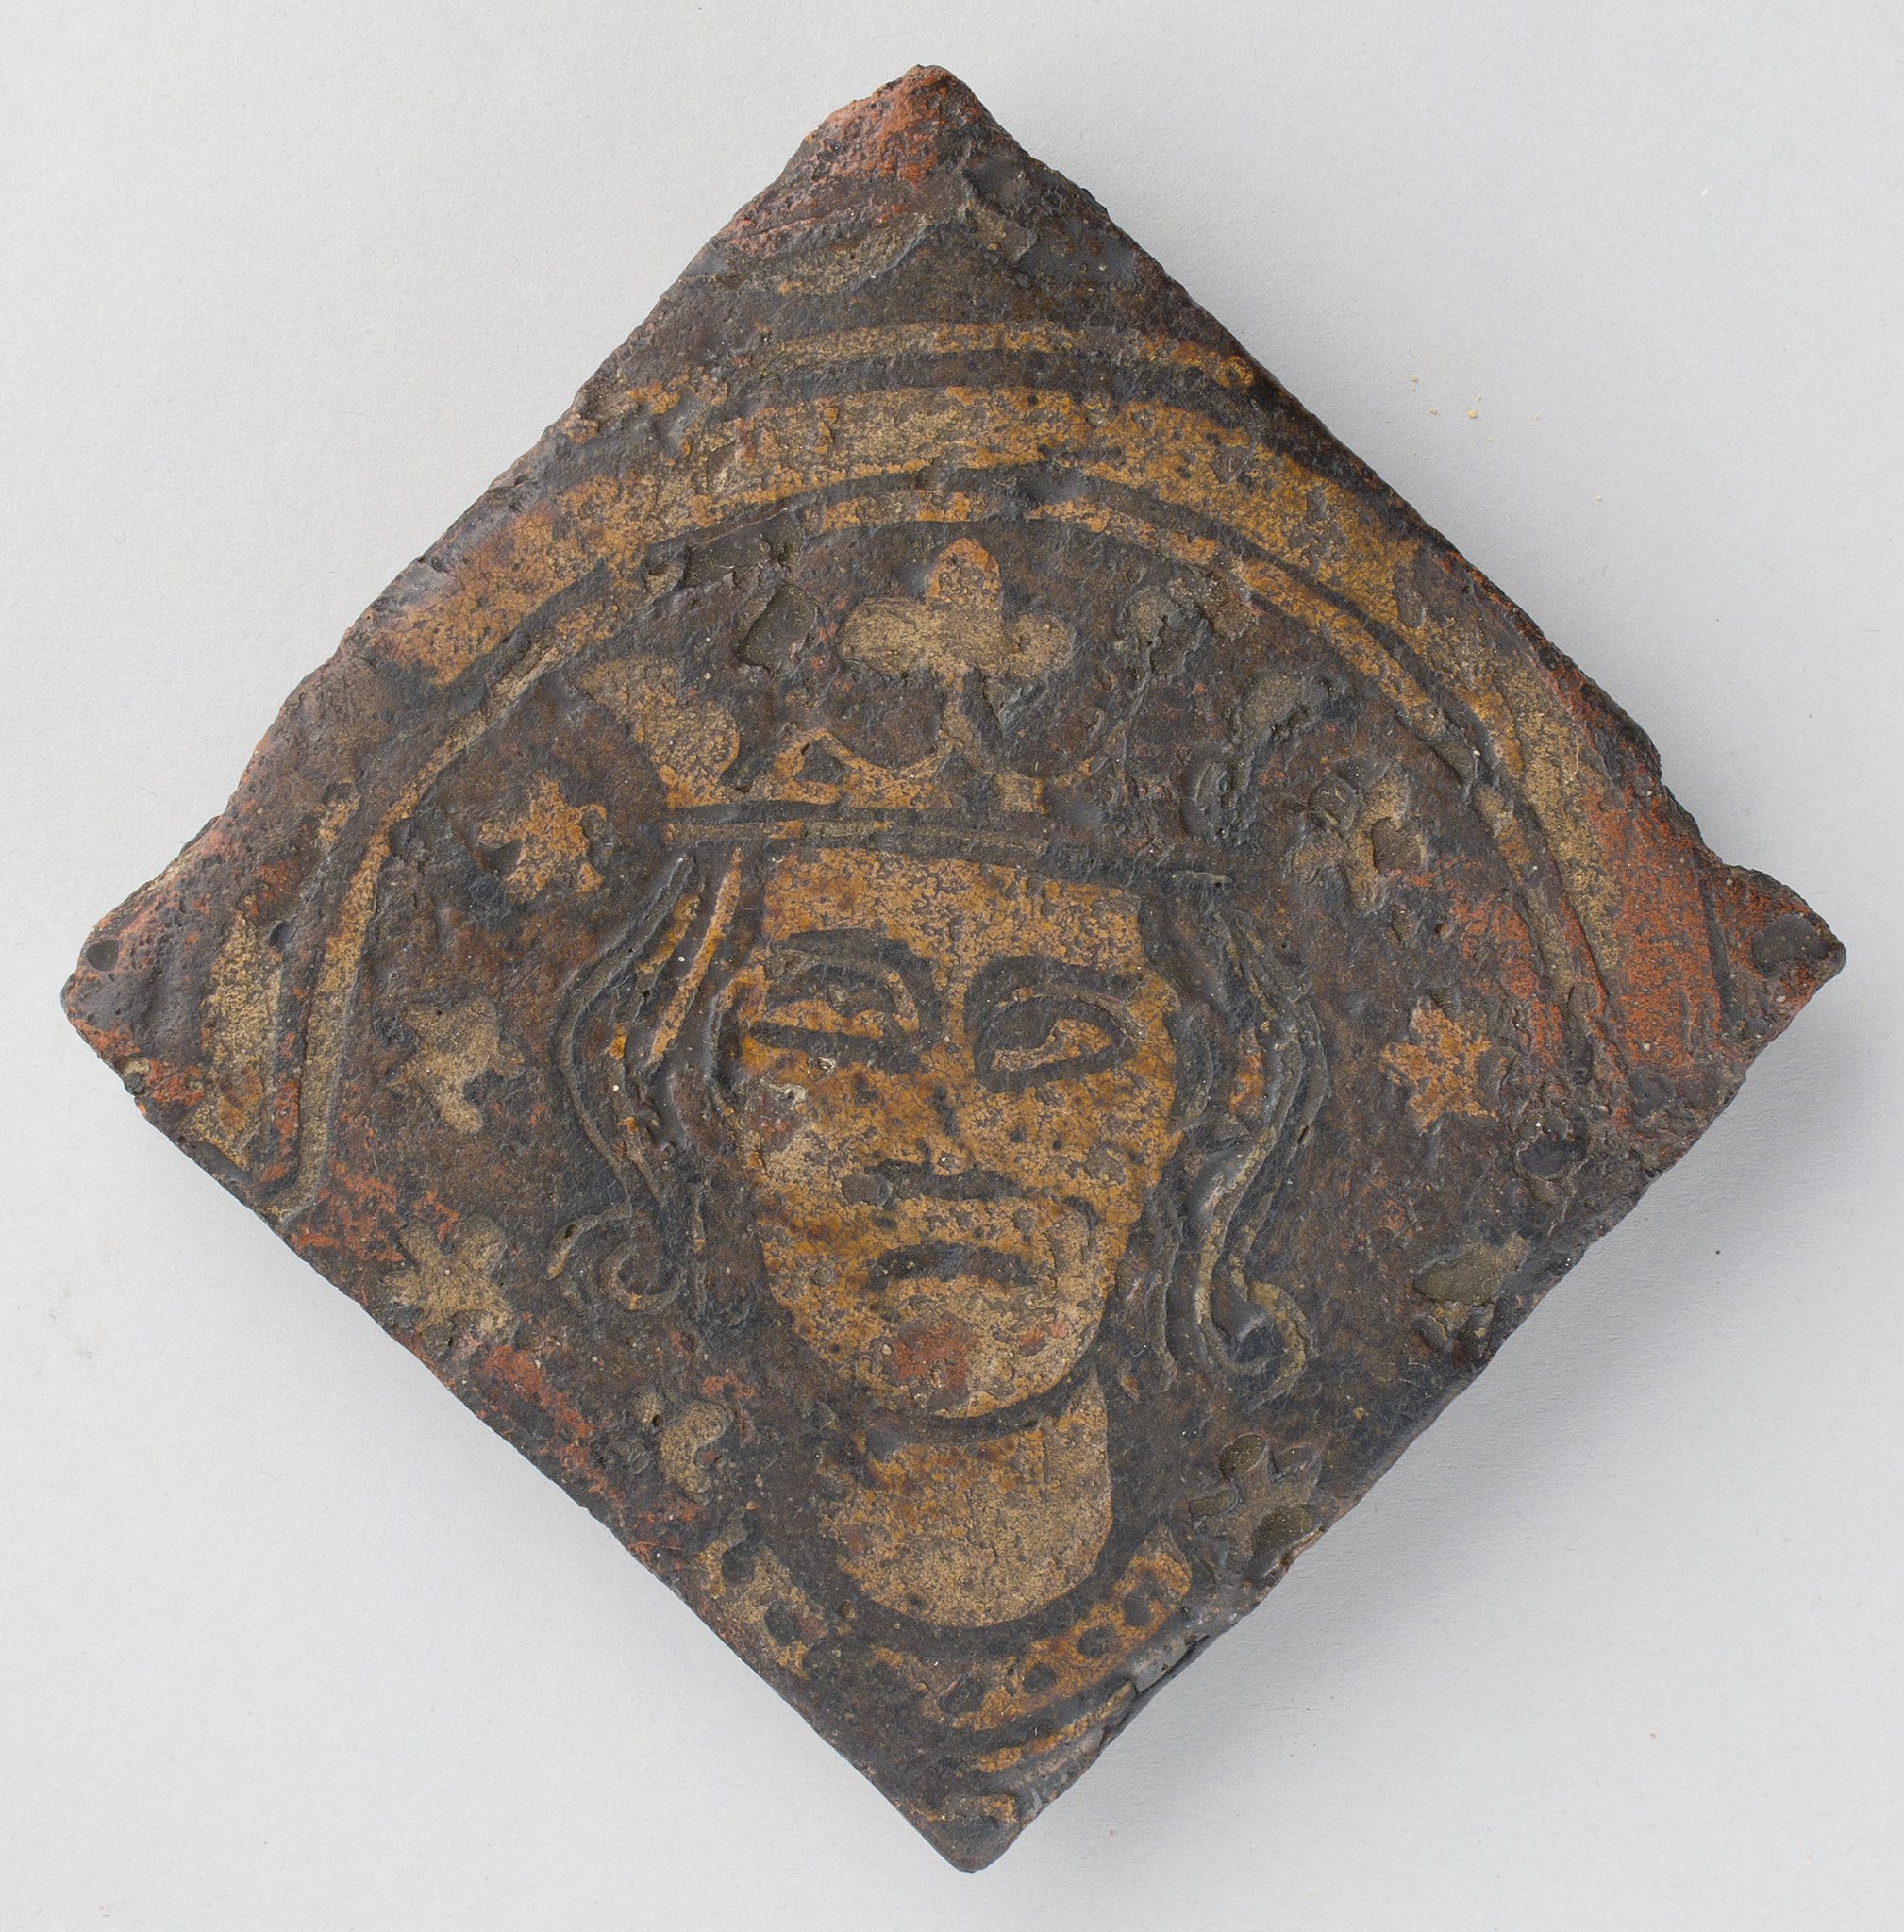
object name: tile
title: Two-Colored Tile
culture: british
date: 1401-1500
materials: earthenware, glaze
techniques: firing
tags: heads,men